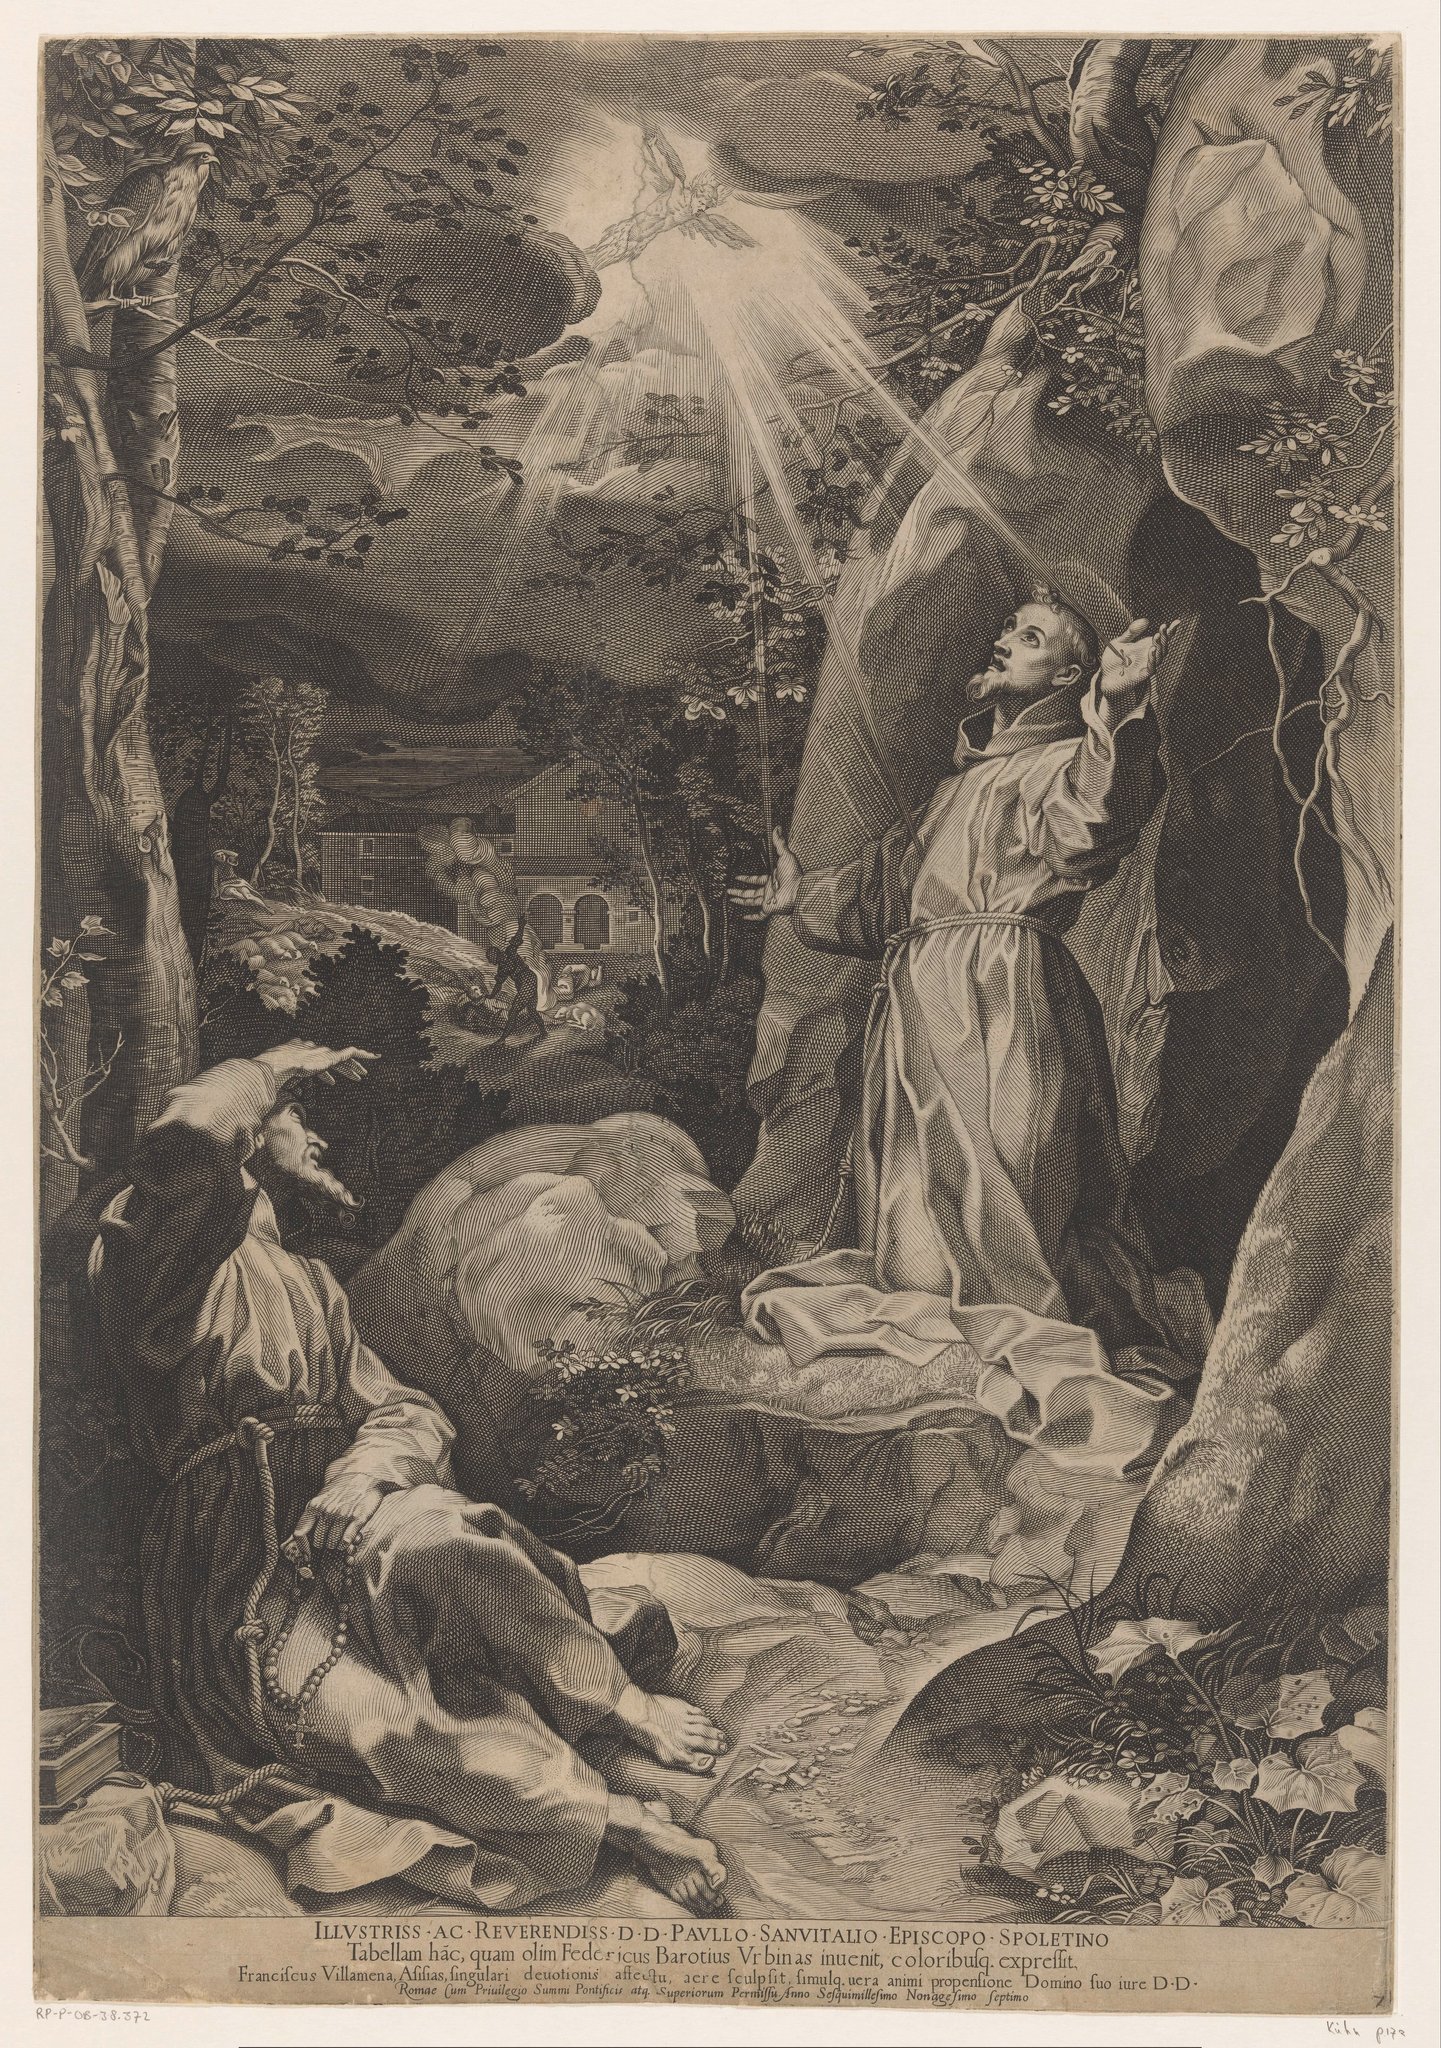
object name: print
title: Franciscus ontvangt de stigmata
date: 1597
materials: paper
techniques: engraving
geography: italy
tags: stigmatization of st. francis of assisi: in retreat on mount alverna, he beholds a vision of christ on the cross enveloped by wings (like a seraph with six wings); rays passing down to the body of the kneeling saint form the marks of the five wounds of christ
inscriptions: number: ‘No. 7’ Lugt, number: ‘7’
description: De heilige Franciscus van Assisi aanschouwt zijn visioen en ontvangt de kruiswonden (stigmata). Links een Franciscaan met een boek. Opdracht en Latijnse tekst in ondermarge.